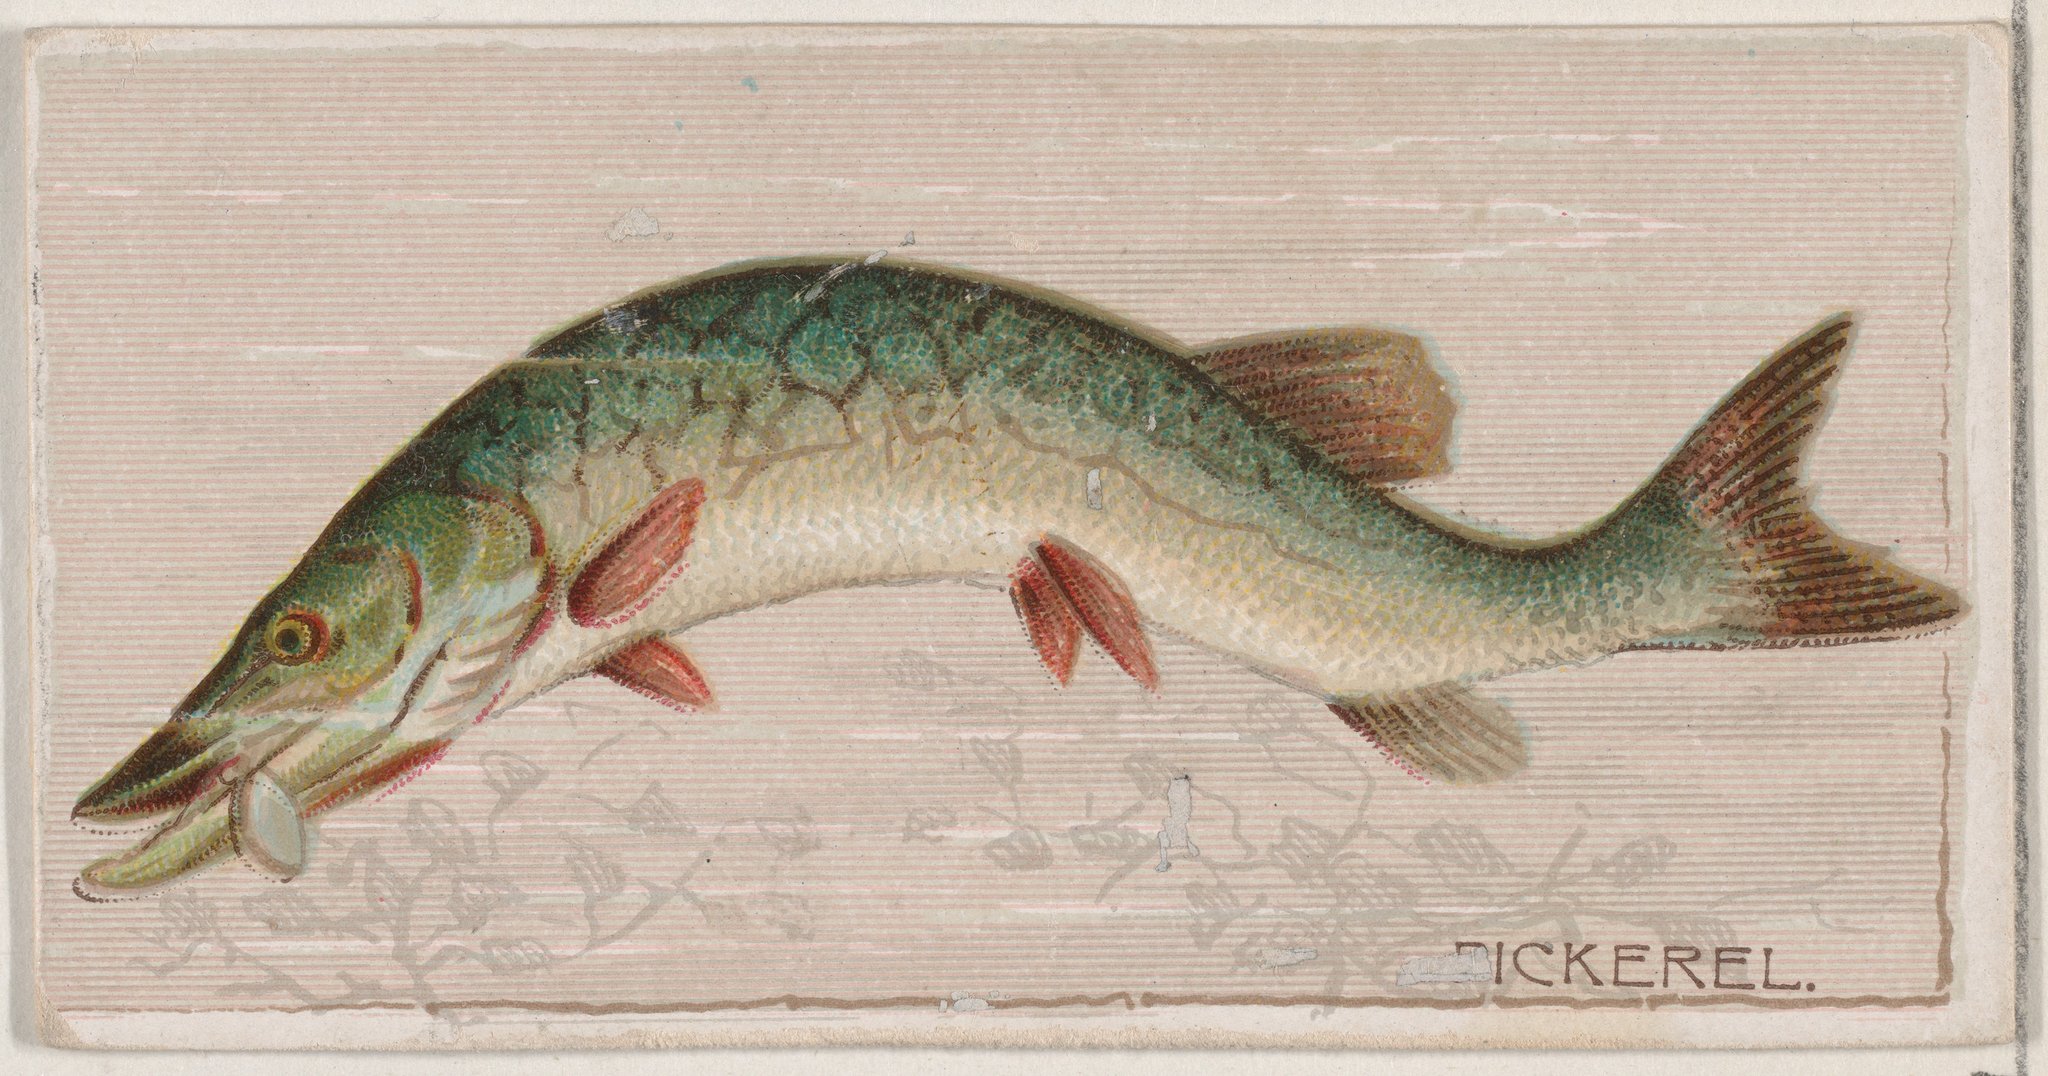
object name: print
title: Pickerel, from the series Fishers and Fish (N74) for Duke brand cigarettes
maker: knapp & company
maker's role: lithographer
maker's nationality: american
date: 1888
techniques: color lithograph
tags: fish